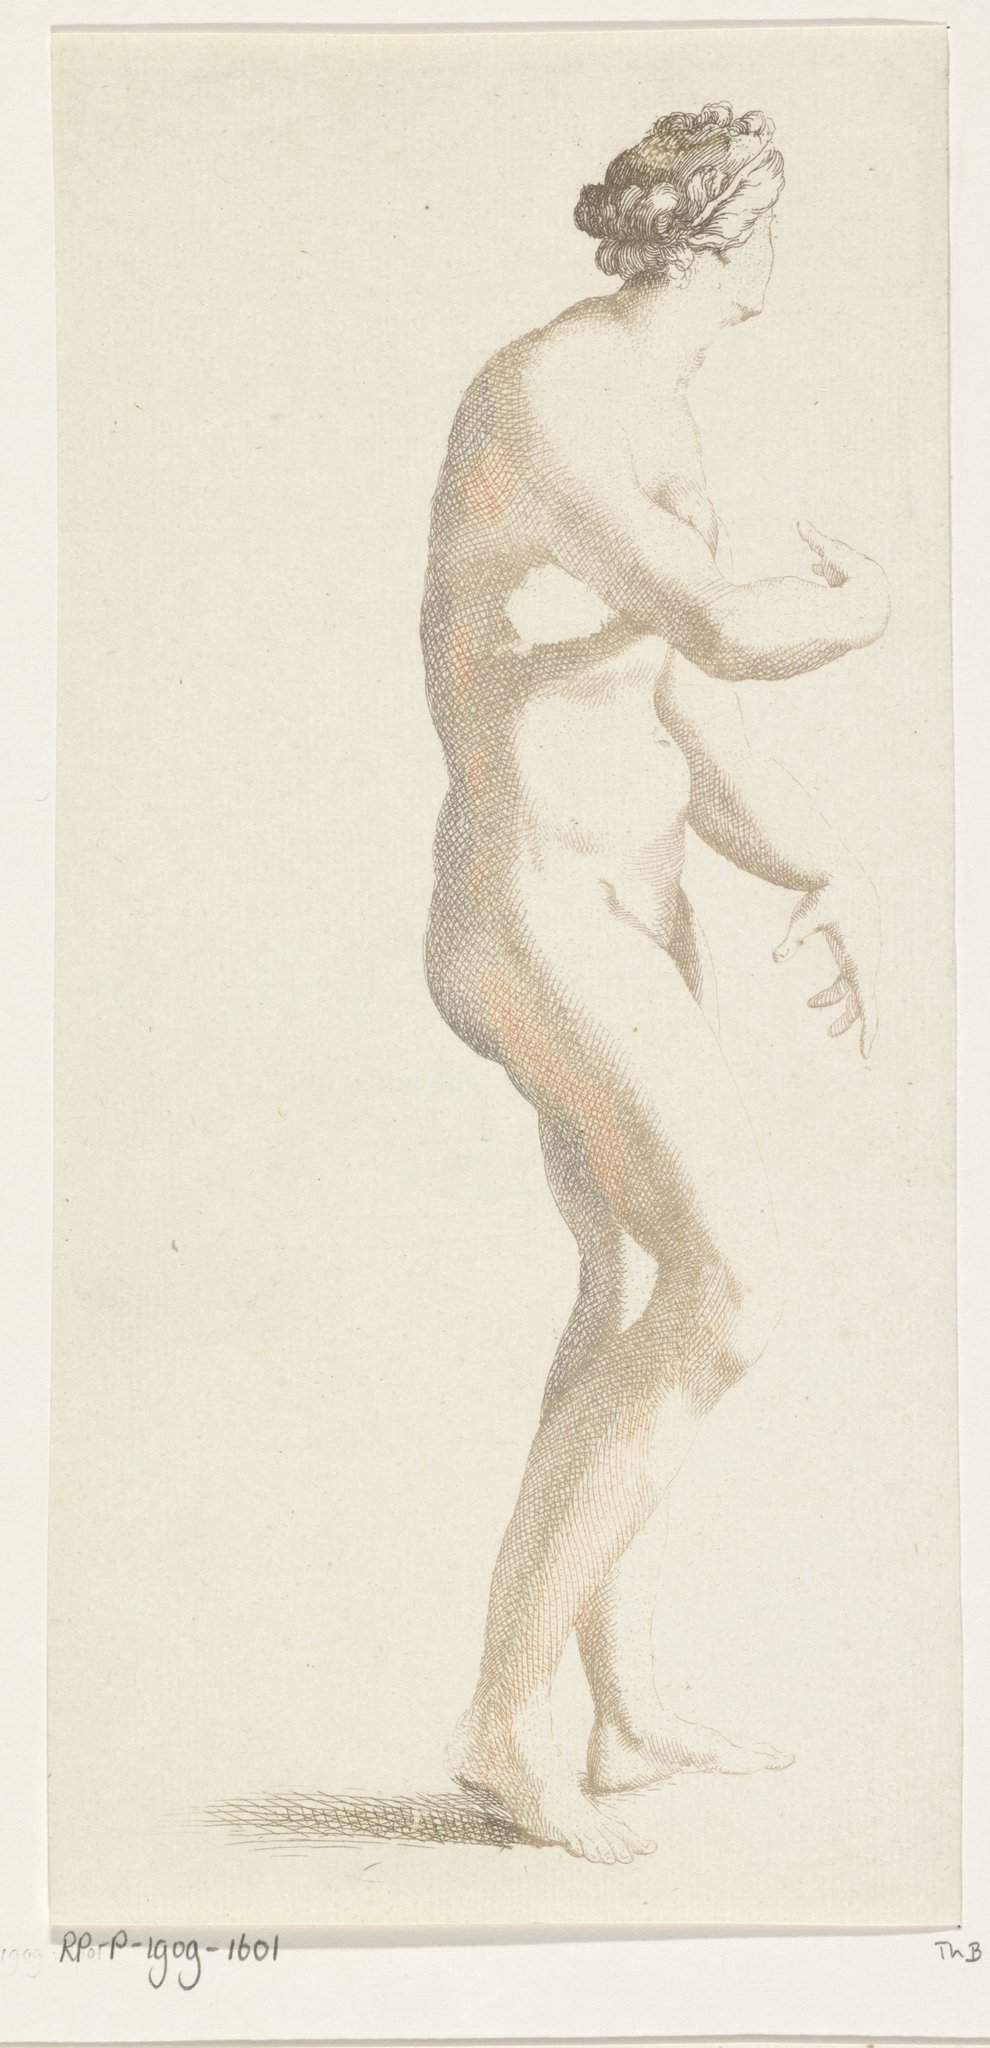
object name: print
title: Standbeeld van Venus de' Medici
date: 1688-1698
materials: paper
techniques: engraving, etching, lithography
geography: netherlands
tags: piece of sculpture, reproduction of a piece of sculpture, (story of) venus (aphrodite)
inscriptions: collector's mark: Lugt 2228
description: Standbeeld van Venus de' Medici gezien op haar zij.